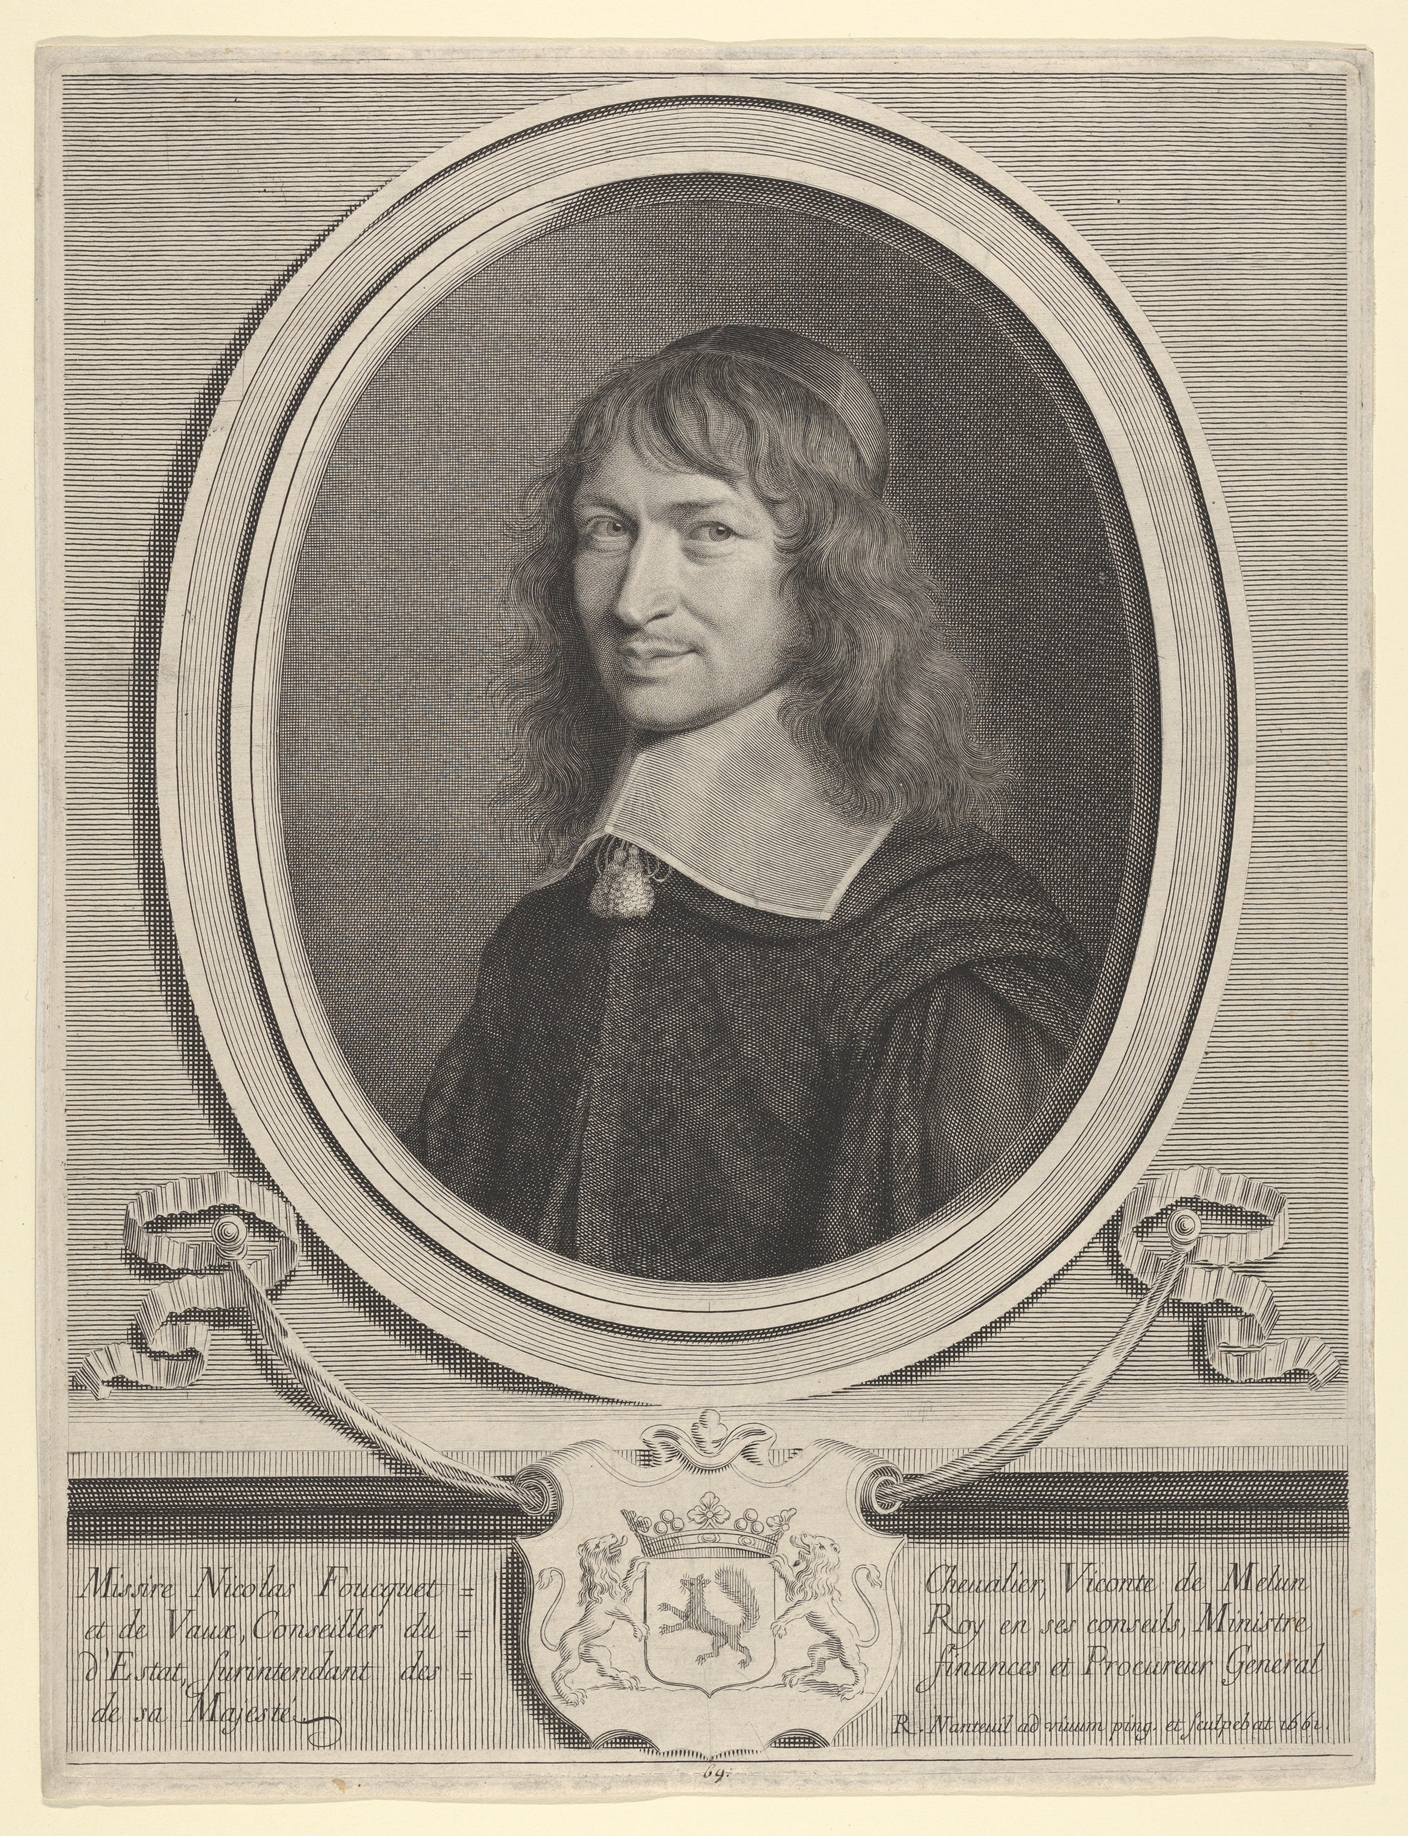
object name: print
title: Nicolas Fouquet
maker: robert nanteuil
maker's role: artist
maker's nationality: french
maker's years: 1623-1678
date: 1661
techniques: engraving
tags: men,portraits,coat of arms